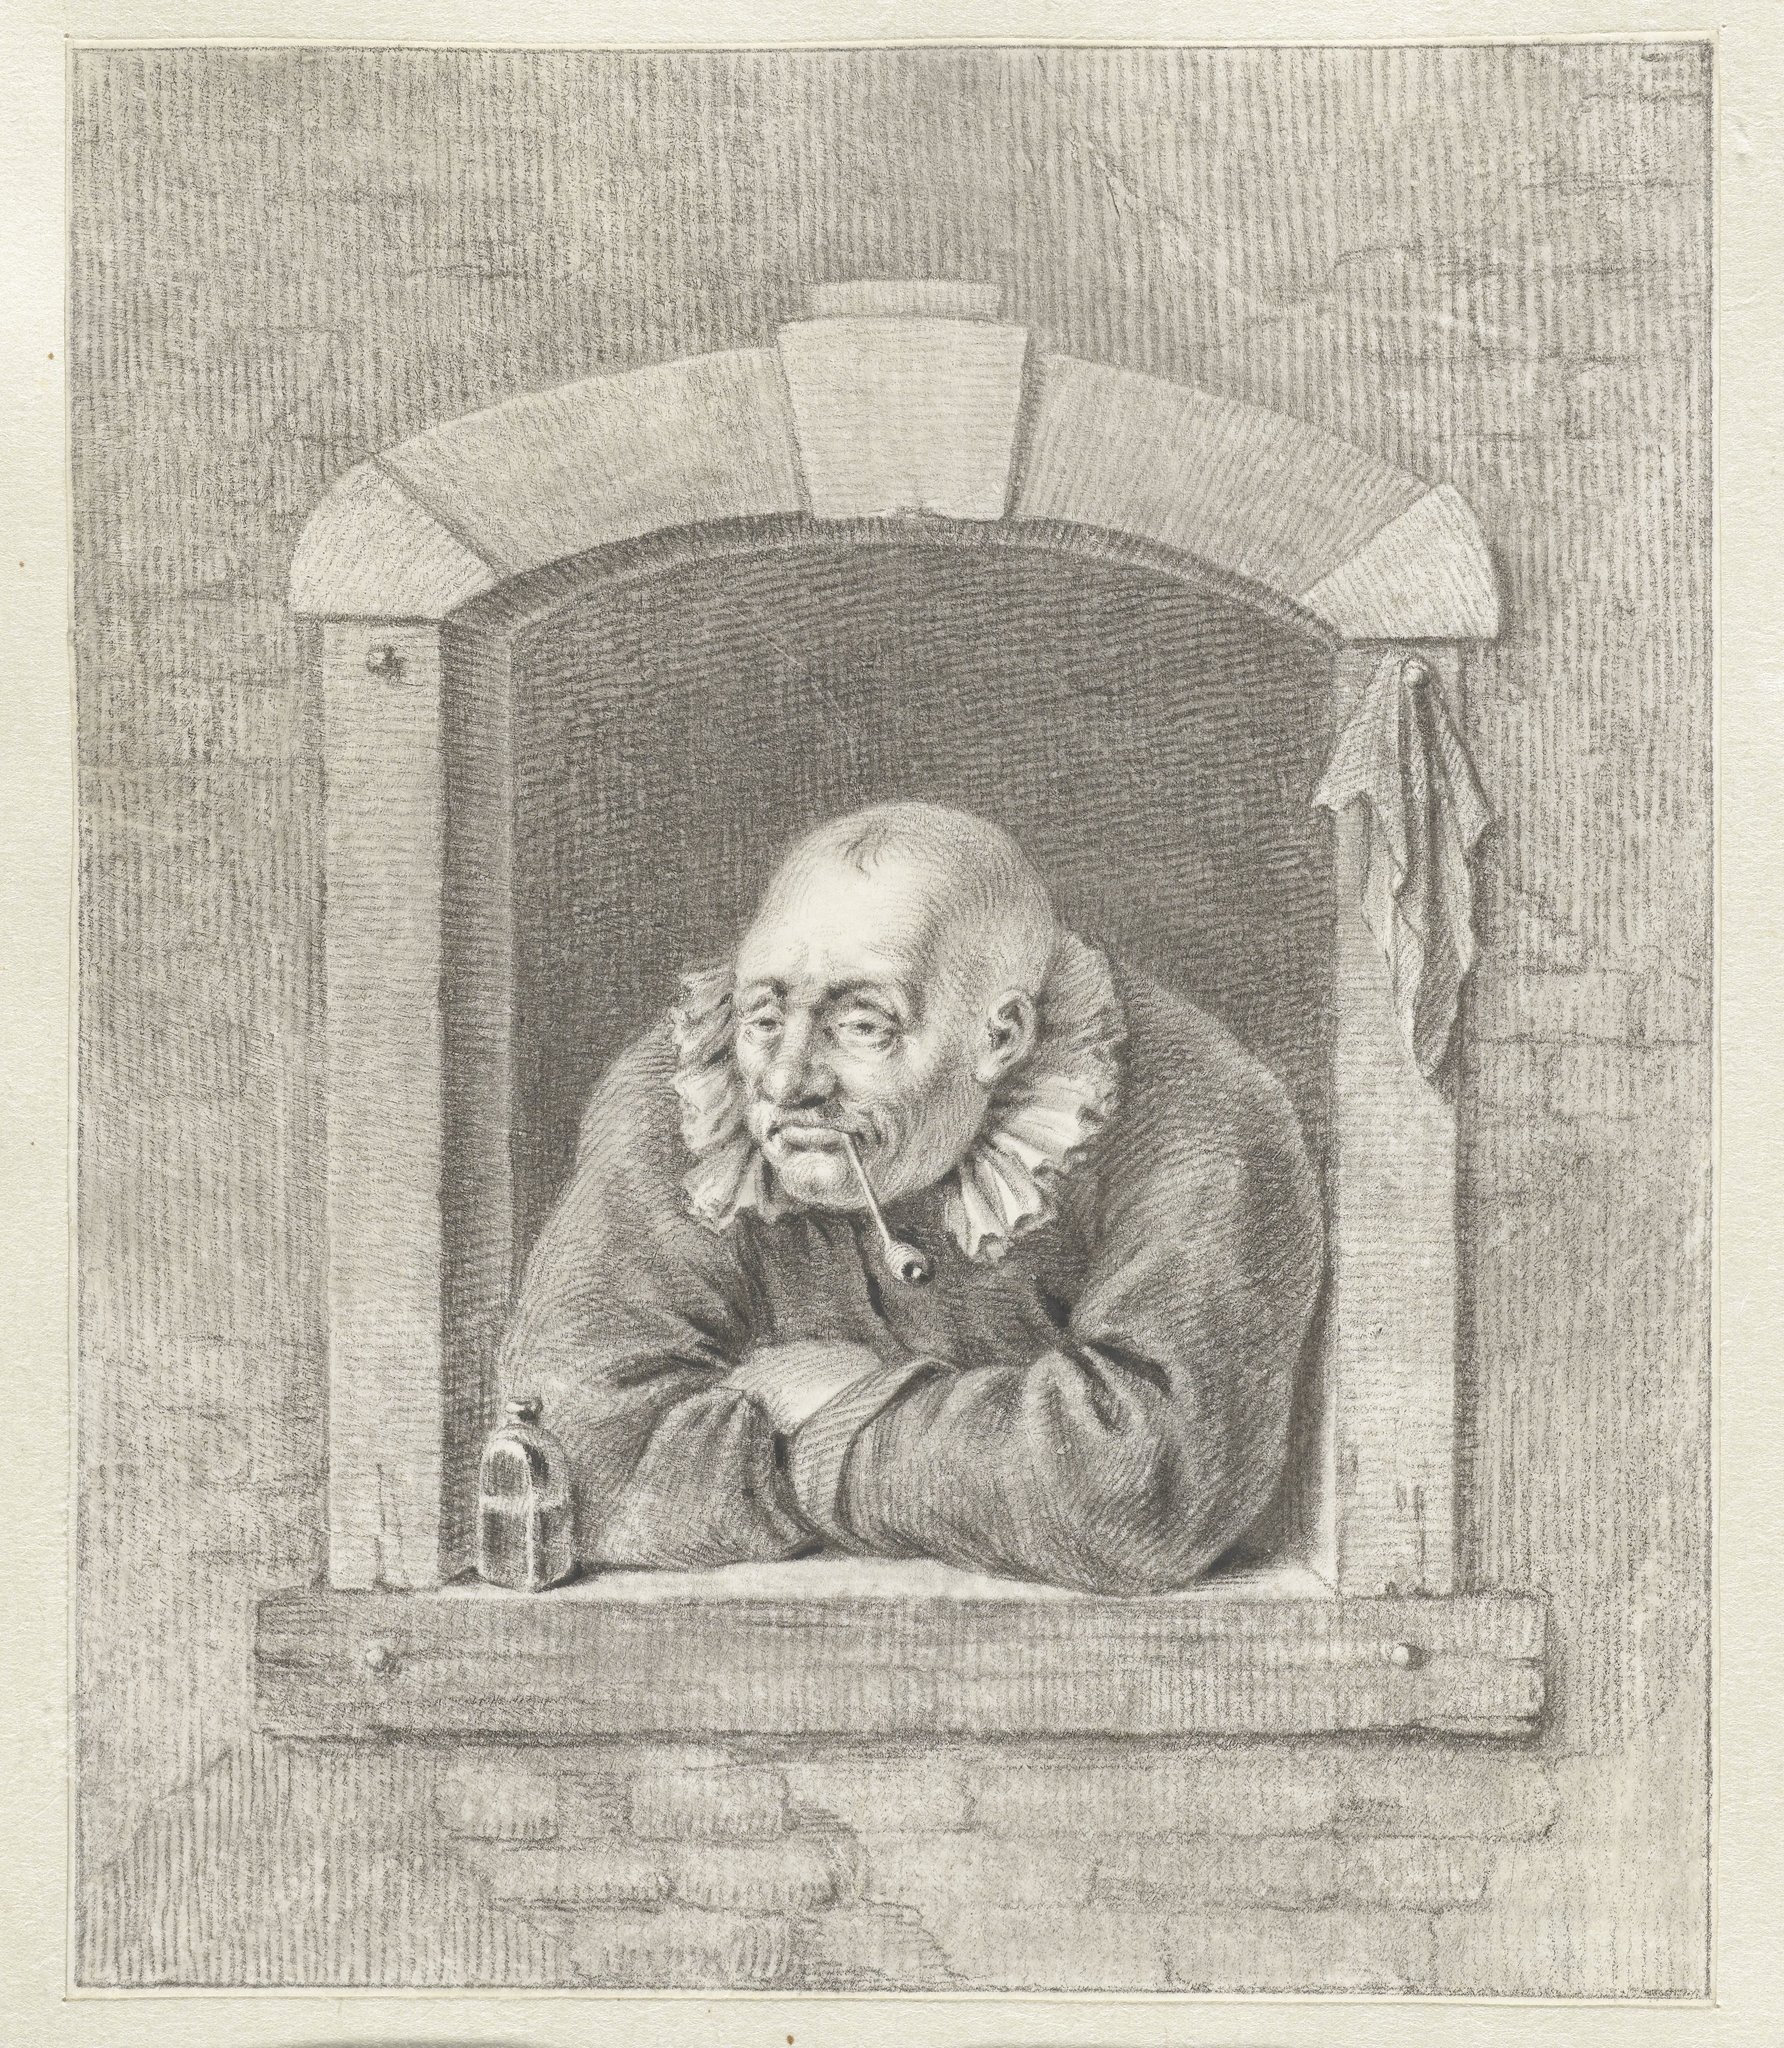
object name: drawing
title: Rokende man in venster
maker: abraham delfos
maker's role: draughtsman, painter, print maker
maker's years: 1731-1820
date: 1741-1820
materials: chalk, parchment, pencil